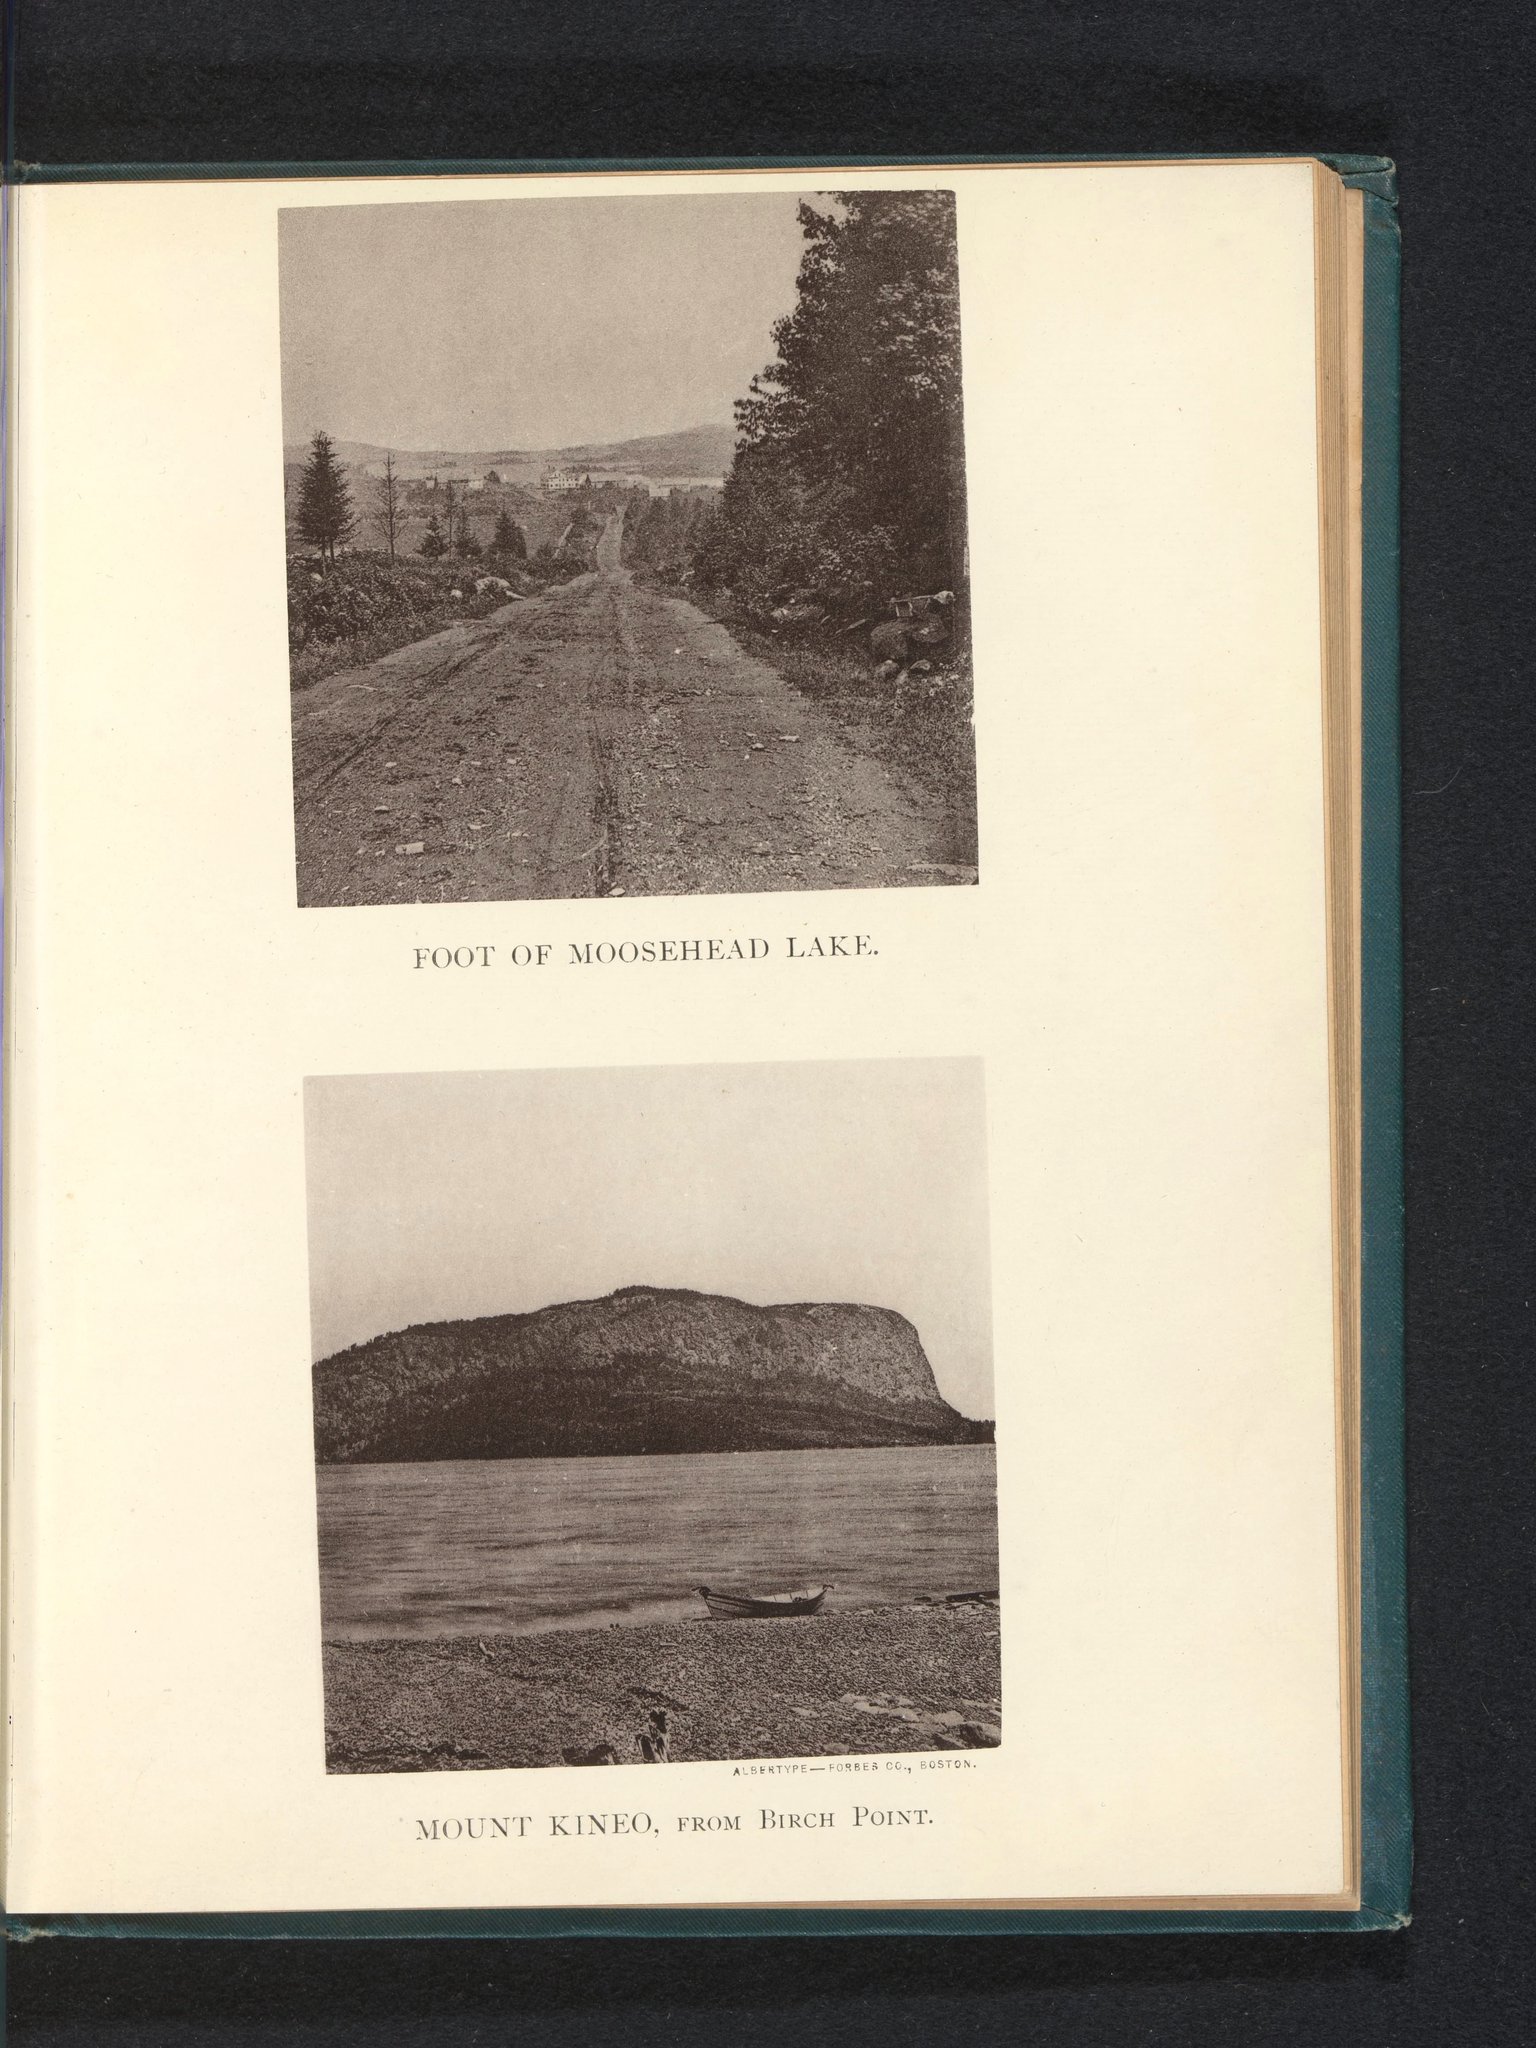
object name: page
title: Gezicht op Mount Kineo en Moosehead Lake, Maine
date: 1875-1880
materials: paper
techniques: photograph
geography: moosehead lake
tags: lake, mountains